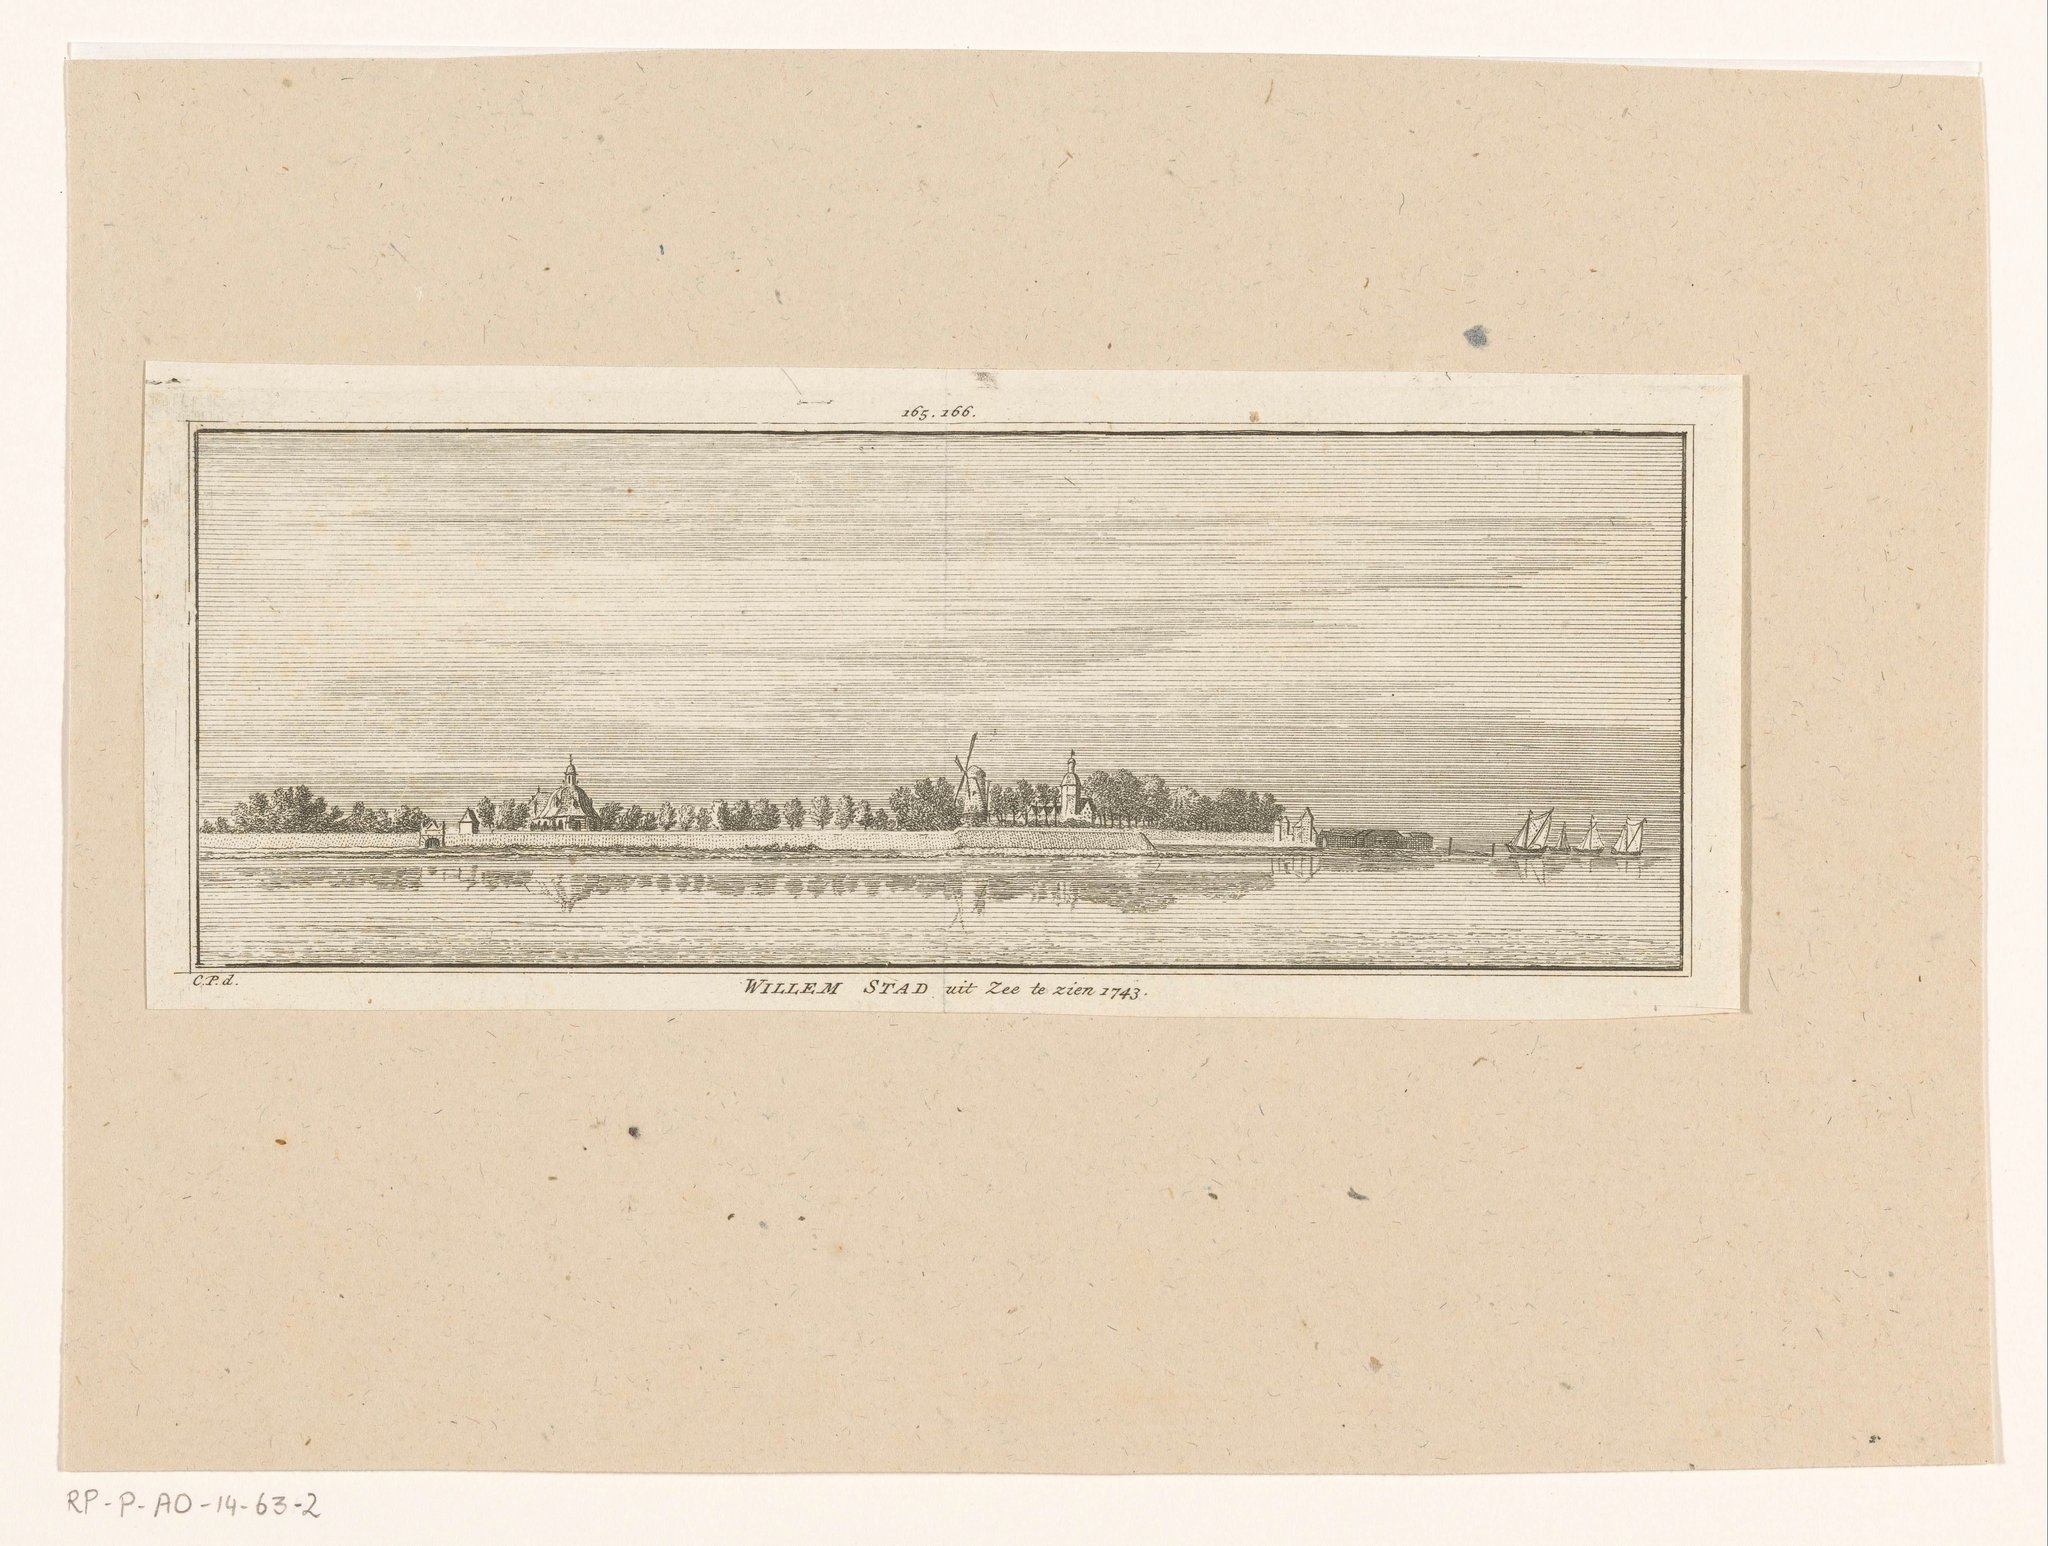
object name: book illustration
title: Gezicht op Willemstad (Noord-Brabant)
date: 1746-1792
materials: paper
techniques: etching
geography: haarlem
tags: sailing-ship, sailing-boat, church (exterior), windmill, prospect of city, town panorama, silhouette of city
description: Prent ook gebruikt in: Het verheerlykt Nederland of kabinet van hedendaagsche gezigten van steden, dorpen (…). 9 delen. Amsterdam: Isaak Tirion en weduwe Isaak Tirion, 1745-1774, dl. 2 (1746), ill. 165-166. Of in: Nederlandsche tafereelen; of eene keurige verzameling van negen honderd fraaije gezigten van steden, dorpen, sloten, oudheden (….). 9 delen. Amsterdam: Jan de Groot, 1792, dl. 2, ill. 165-166.